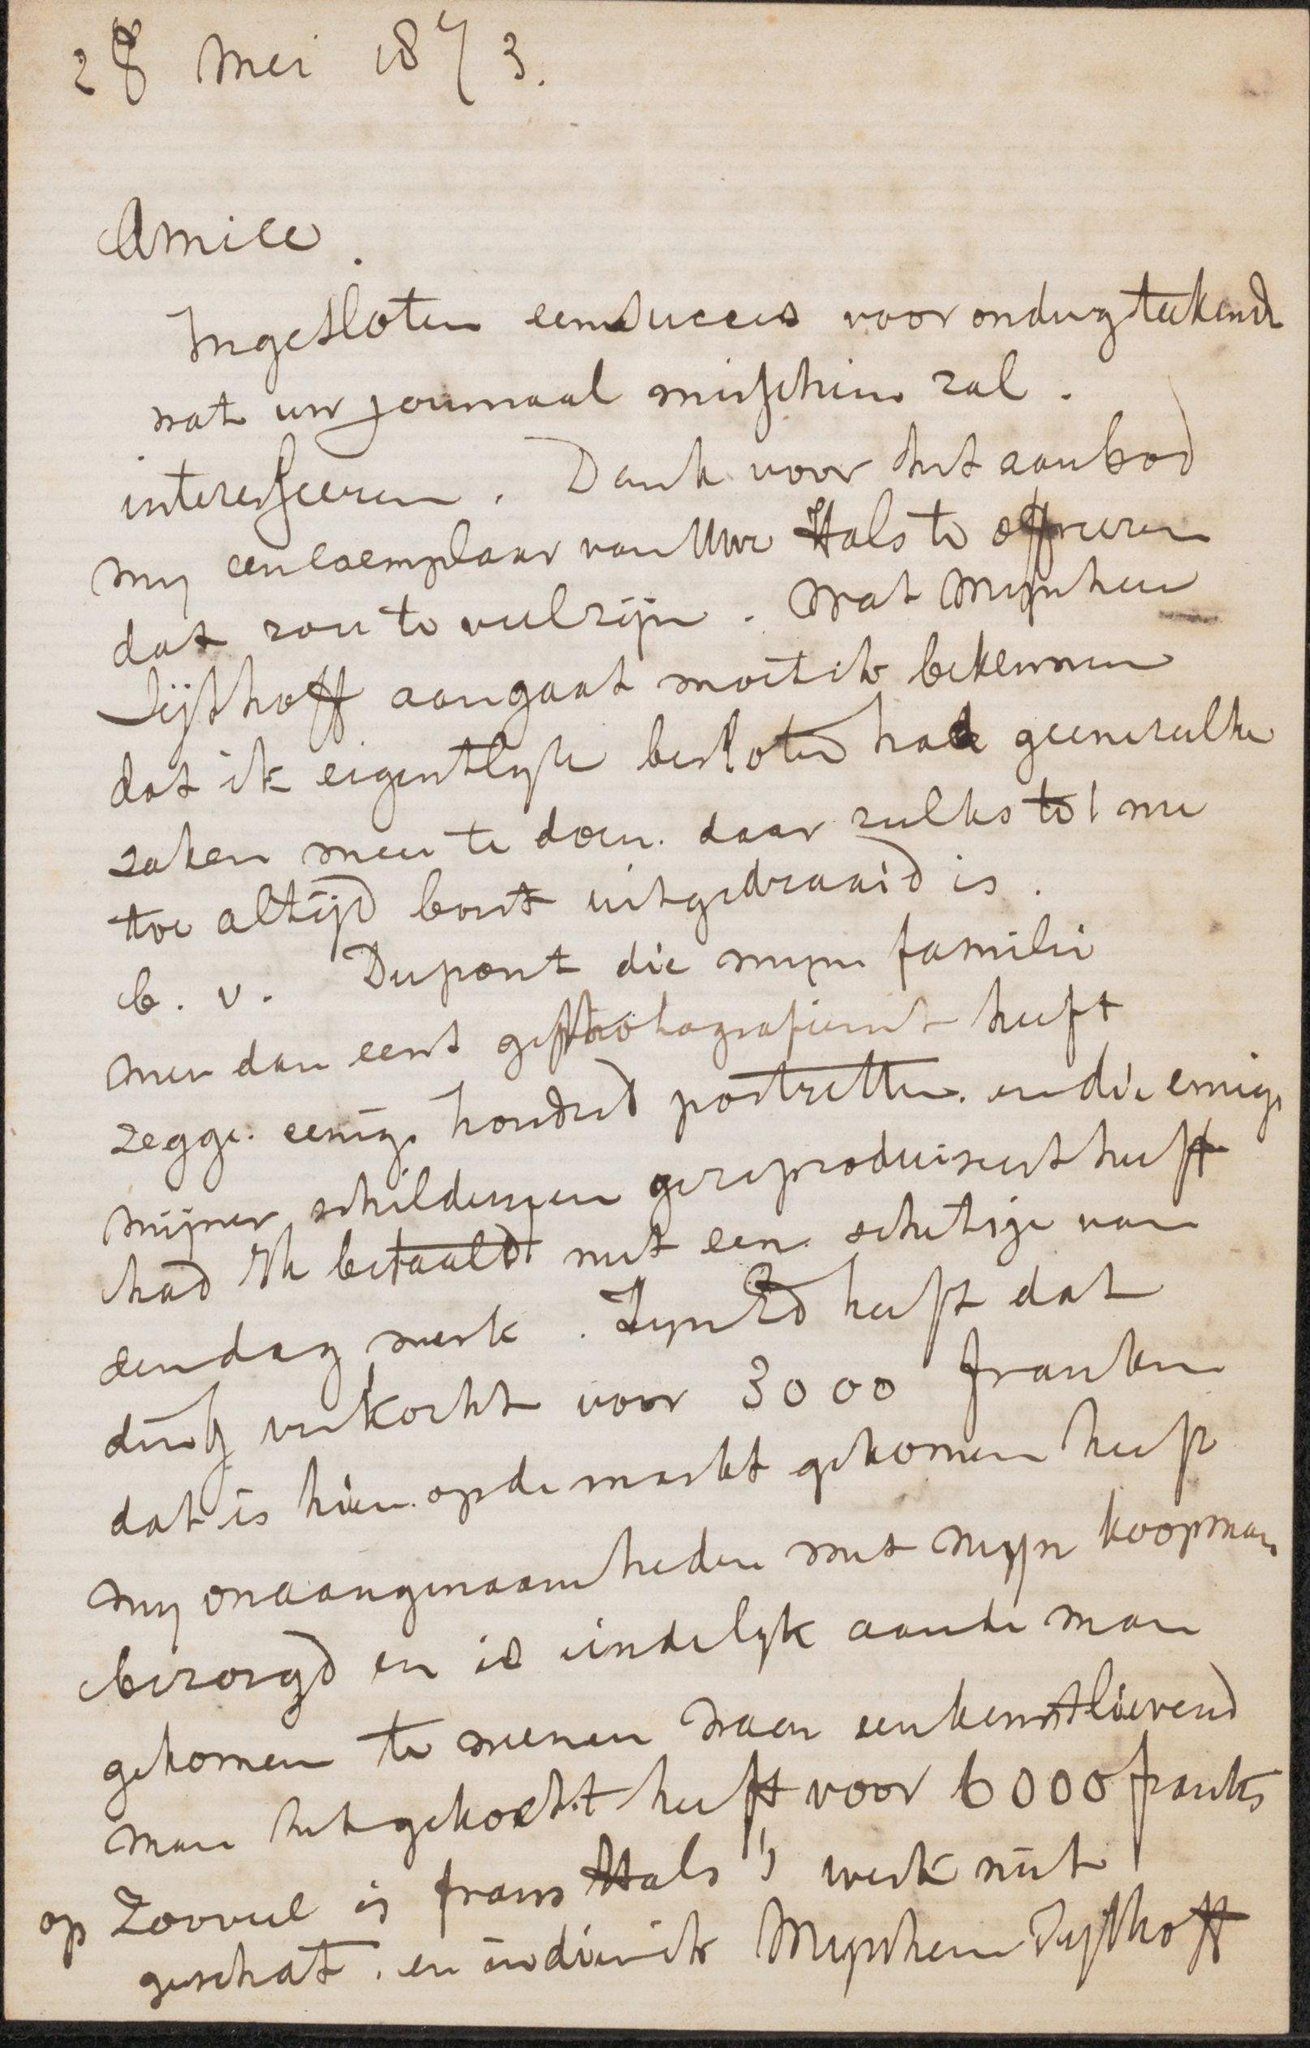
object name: letter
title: Brief aan Carel Vosmaer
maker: lourens alma tadema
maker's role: draughtsman, print maker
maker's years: 1836-1912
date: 1873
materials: ink, paper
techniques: pen, writing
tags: frans hals, the hague, print maker, draughtsman, carel vosmaer, albertus willem sijthoff, printer, publisher, the graphic arts, painting (including book-illumination, miniature-painting), historical persons (portraits and scenes from the life), money, amsterdam